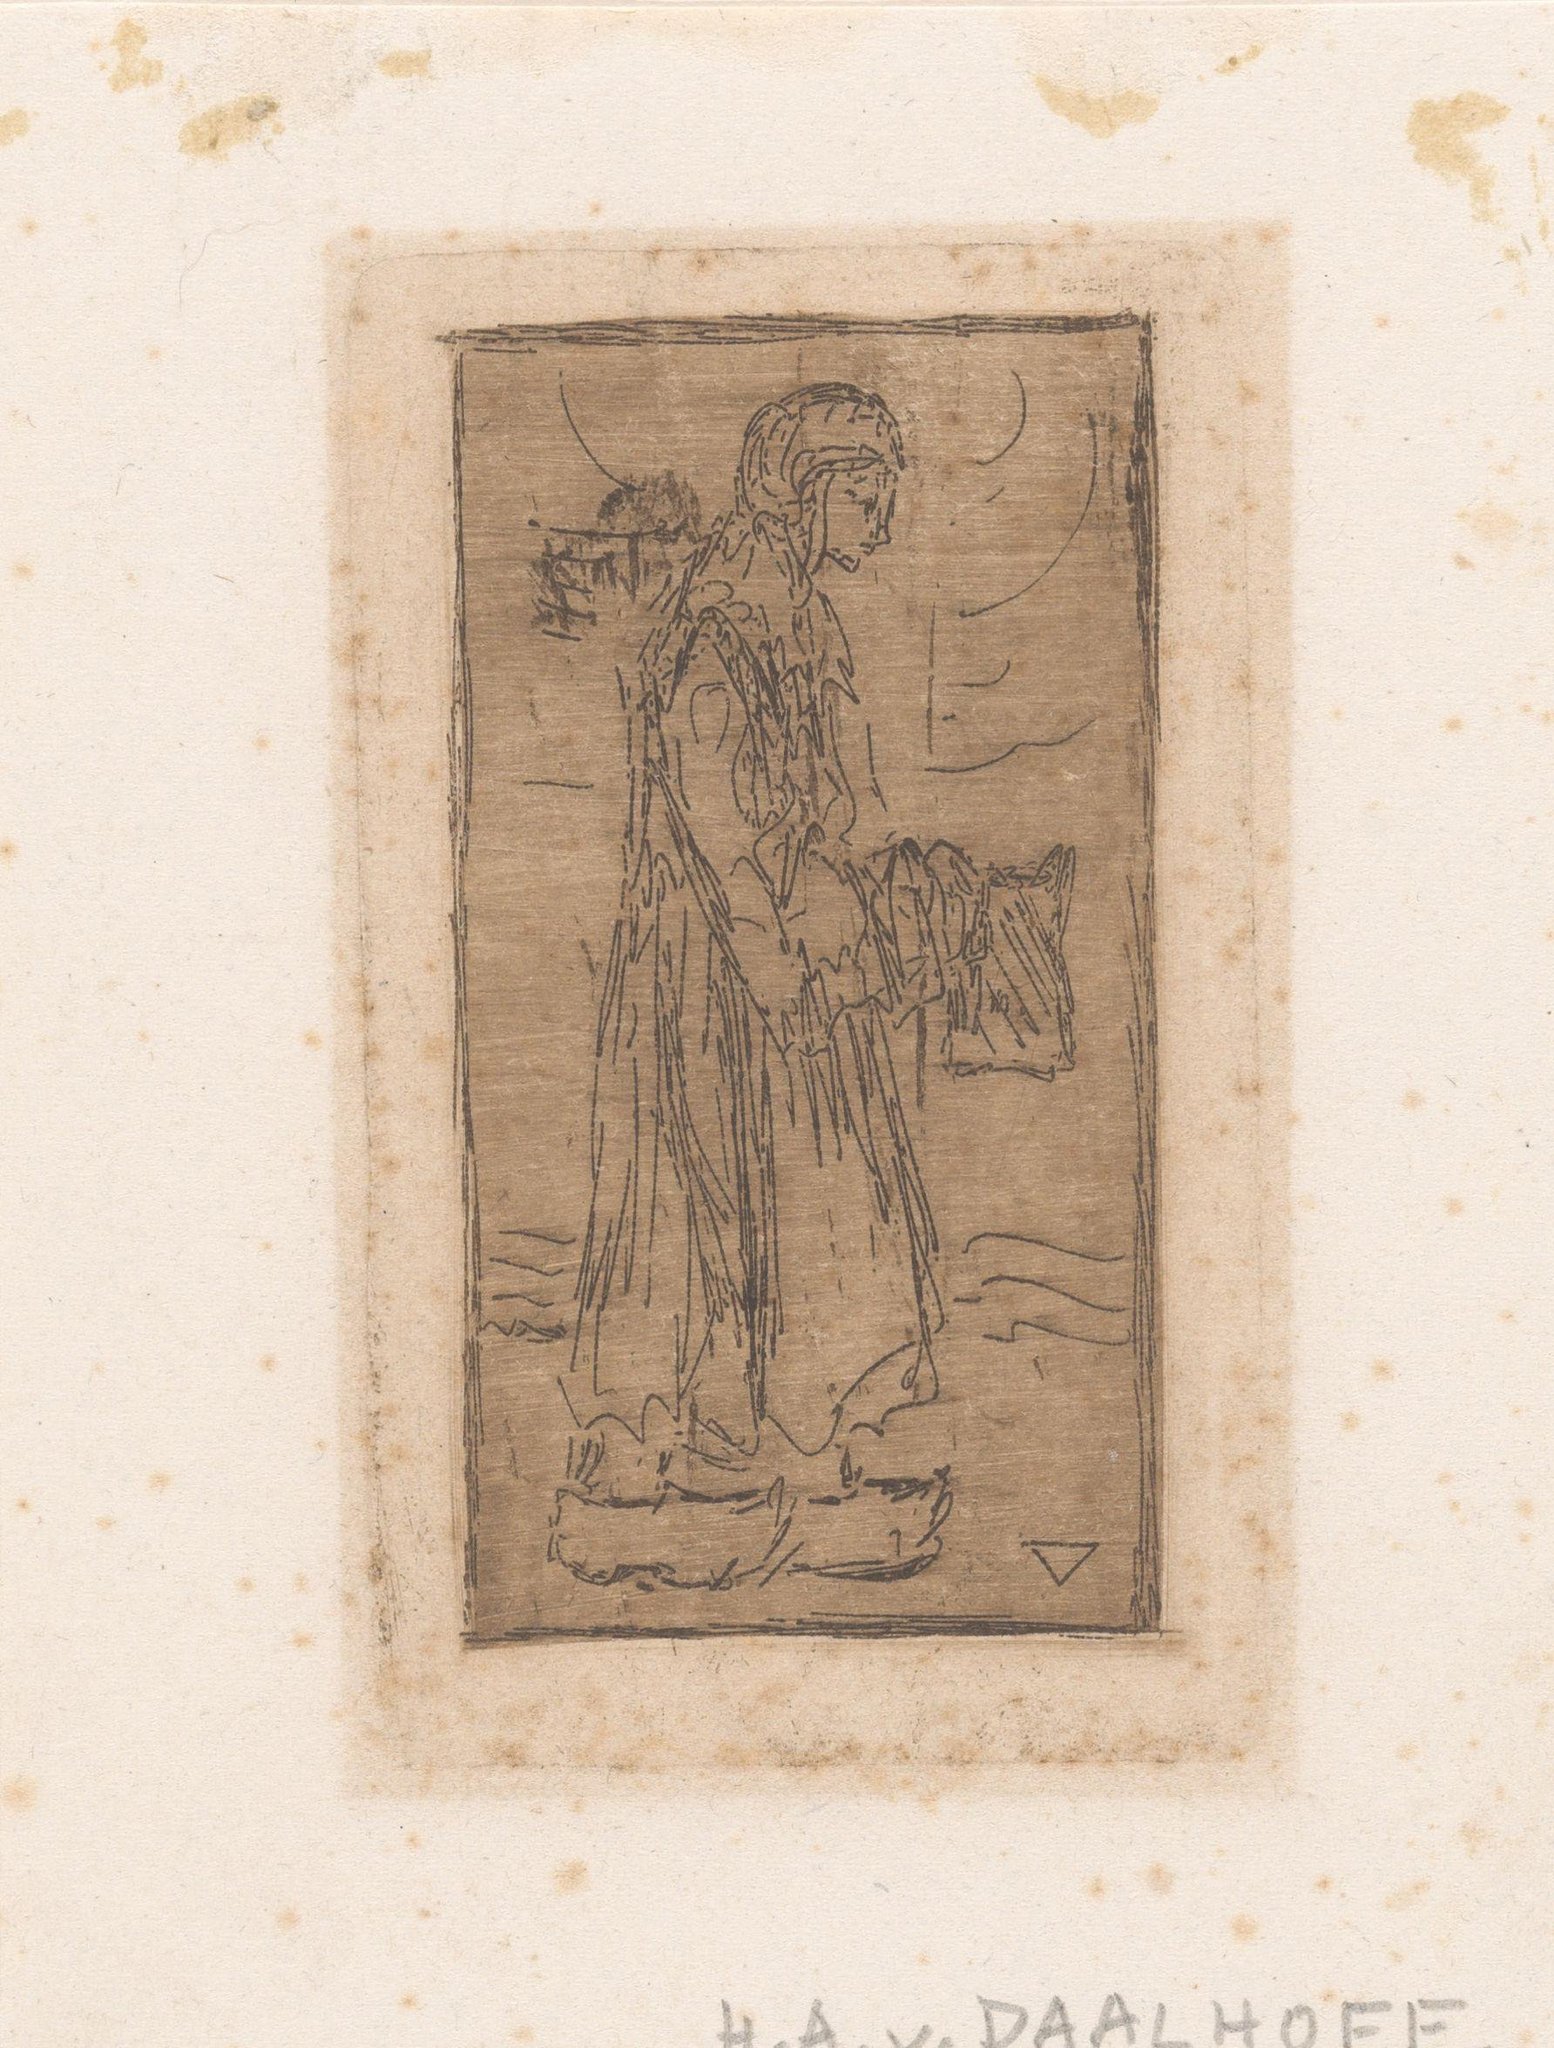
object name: print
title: Vrouw lopend op klompen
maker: herman antonius van daalhoff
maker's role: draughtsman, print maker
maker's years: 1867-1953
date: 1877-1947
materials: paper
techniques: etching, intaglio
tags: wooden shoes, clogs, walking - aa - female human figure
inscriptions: collector's mark: Lugt 2228